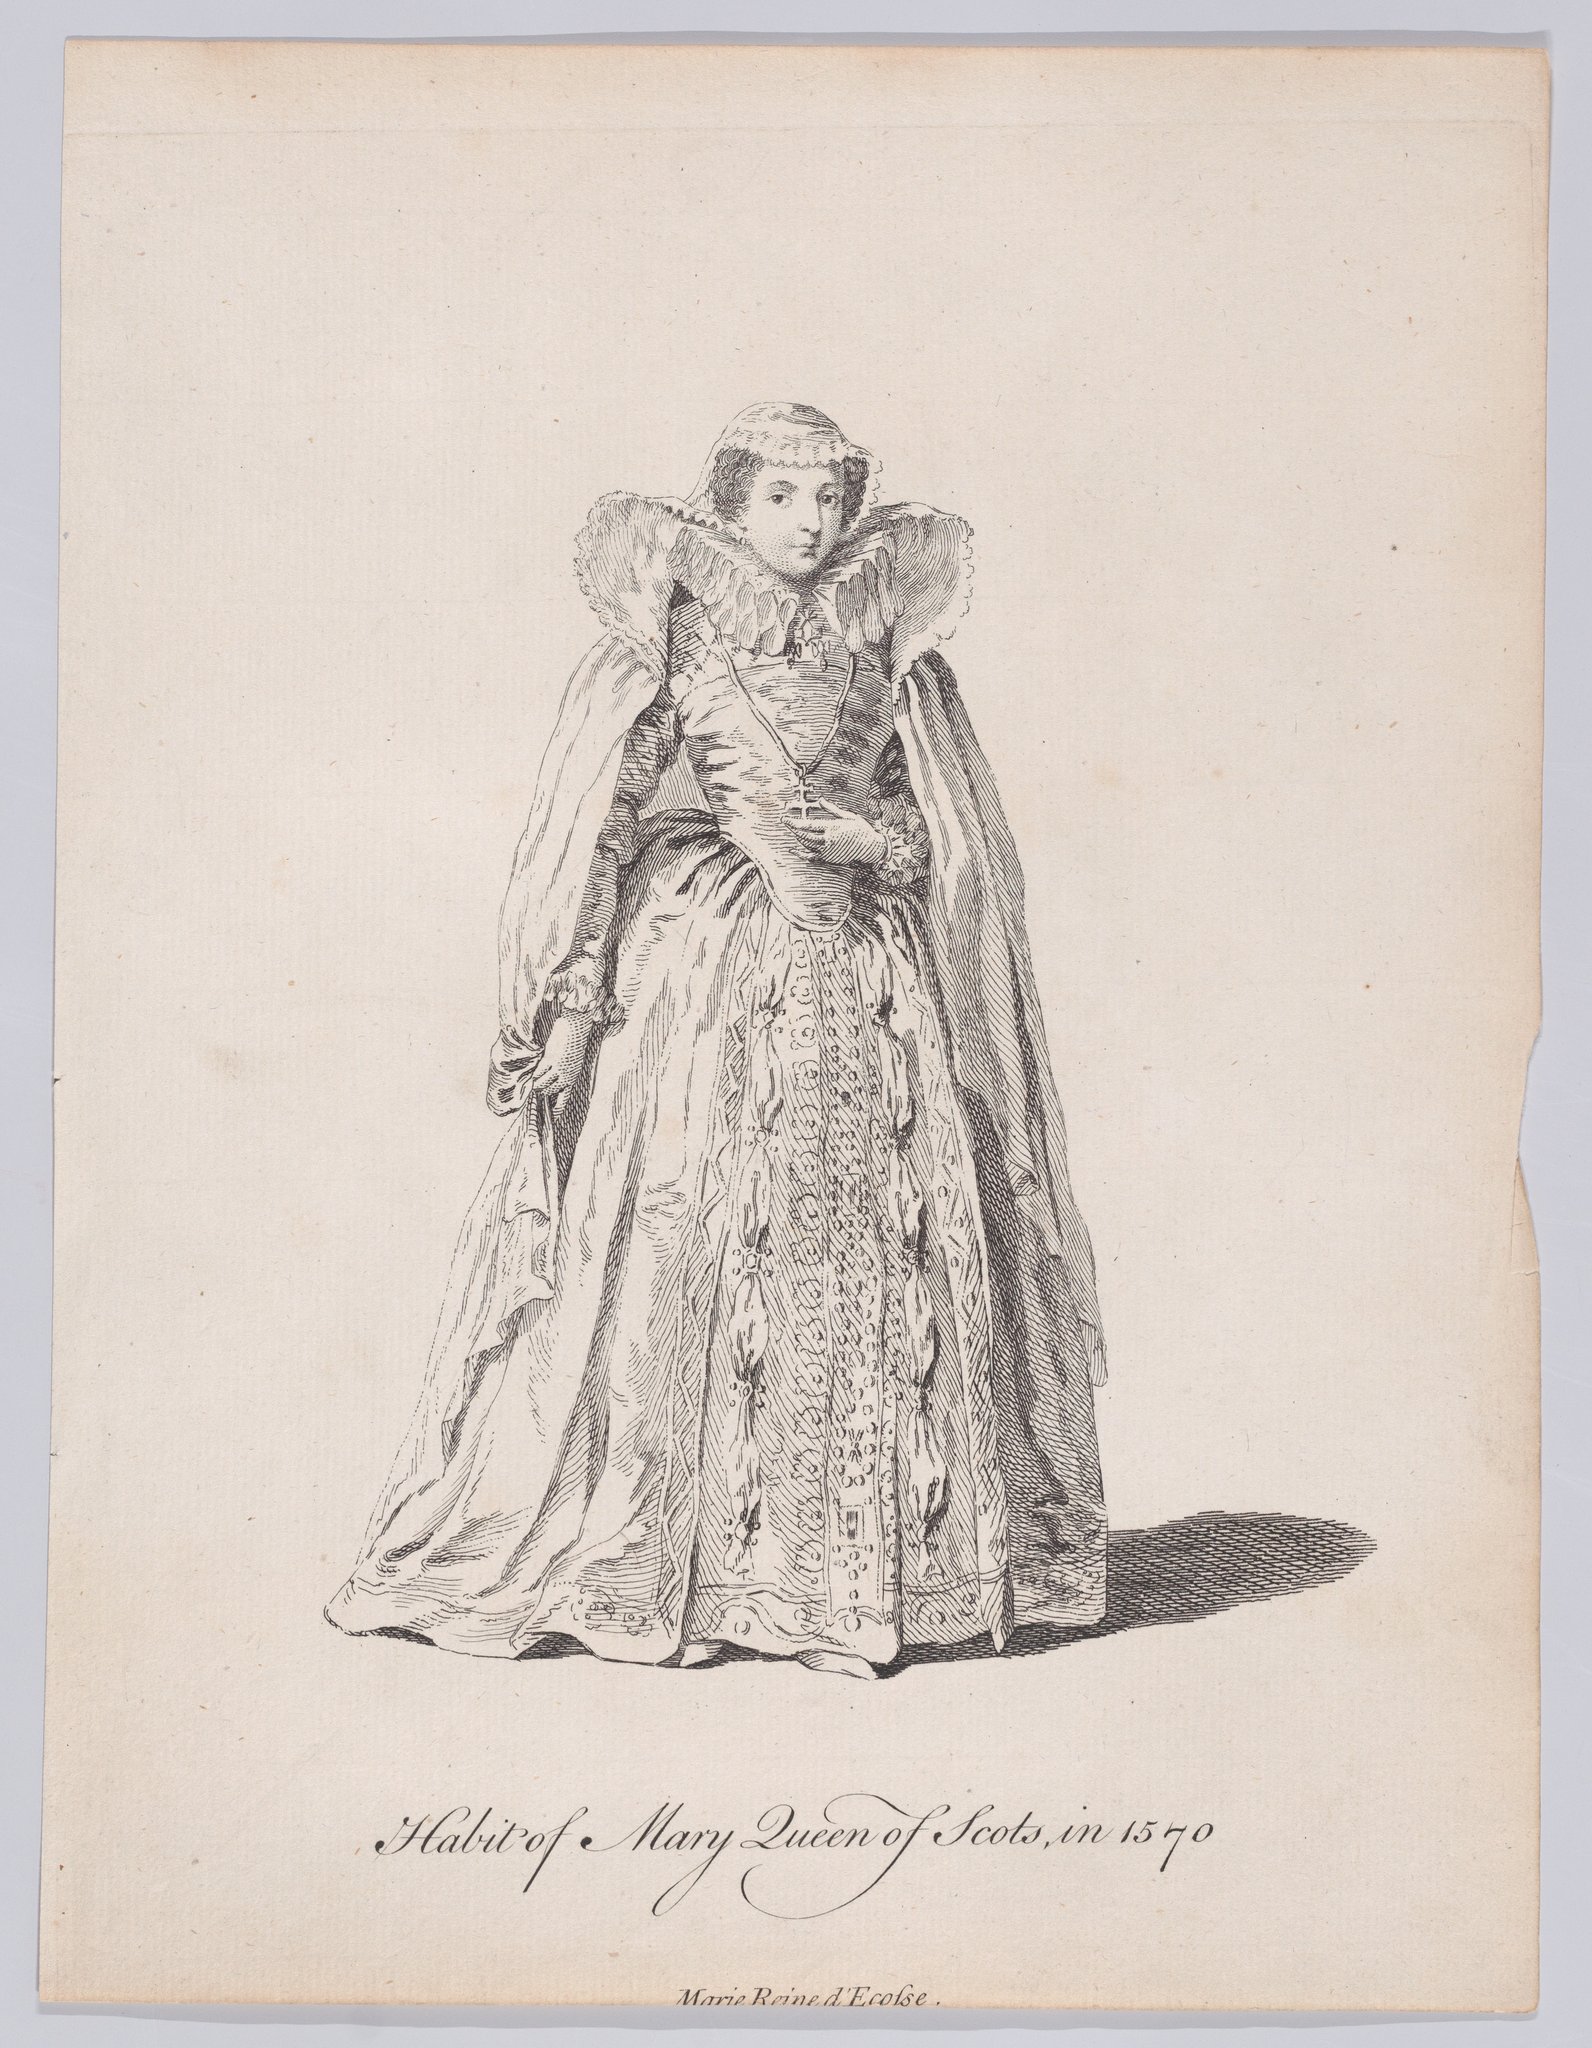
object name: print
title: Habit of Mary Queen of Scots, in 1570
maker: mary, queen of scots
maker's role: sitter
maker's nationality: scottish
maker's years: 1542-1587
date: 1767-1833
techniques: engraving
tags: queens,women,mary queen of scots